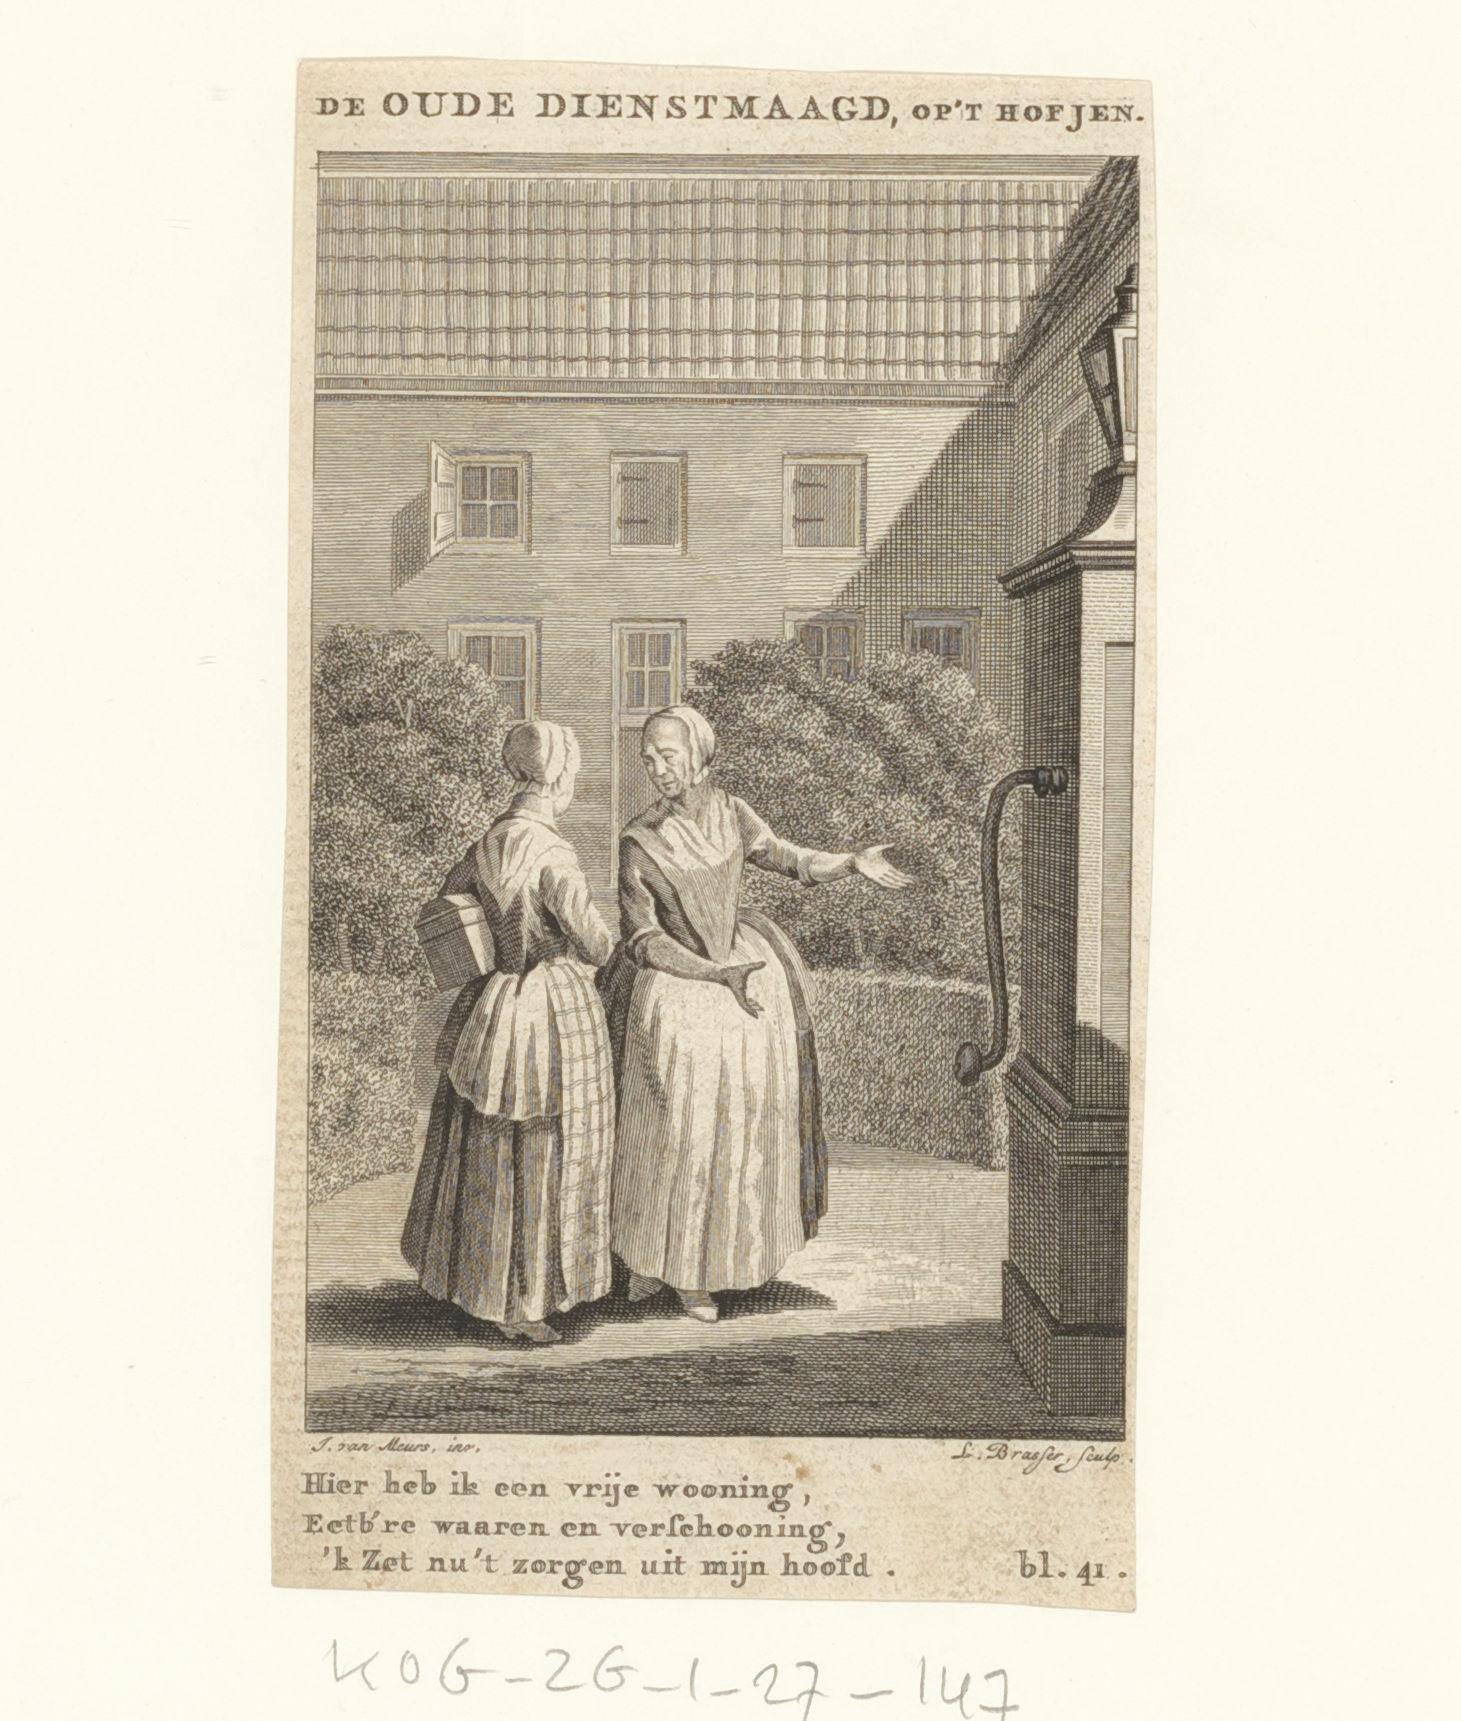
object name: book illustration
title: De oude dienstmaagd, op 't hofjen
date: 1789-1791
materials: paper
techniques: engraving, etching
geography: netherlands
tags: alms-house (dutch: 'hofje'), old woman, maid ~ house personnel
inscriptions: collector's mark: Lugt 1641, collector's mark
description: Gebruikt als illustratie in: Volks-liedjes, uitgegeven door de Maatschappij tot Nut van 't Algemeen, Amsterdam: Harmanus Keijzer, Arend Fokke en Cornelis de Vries, 3 delen, 1789-1791, p. 38/39.